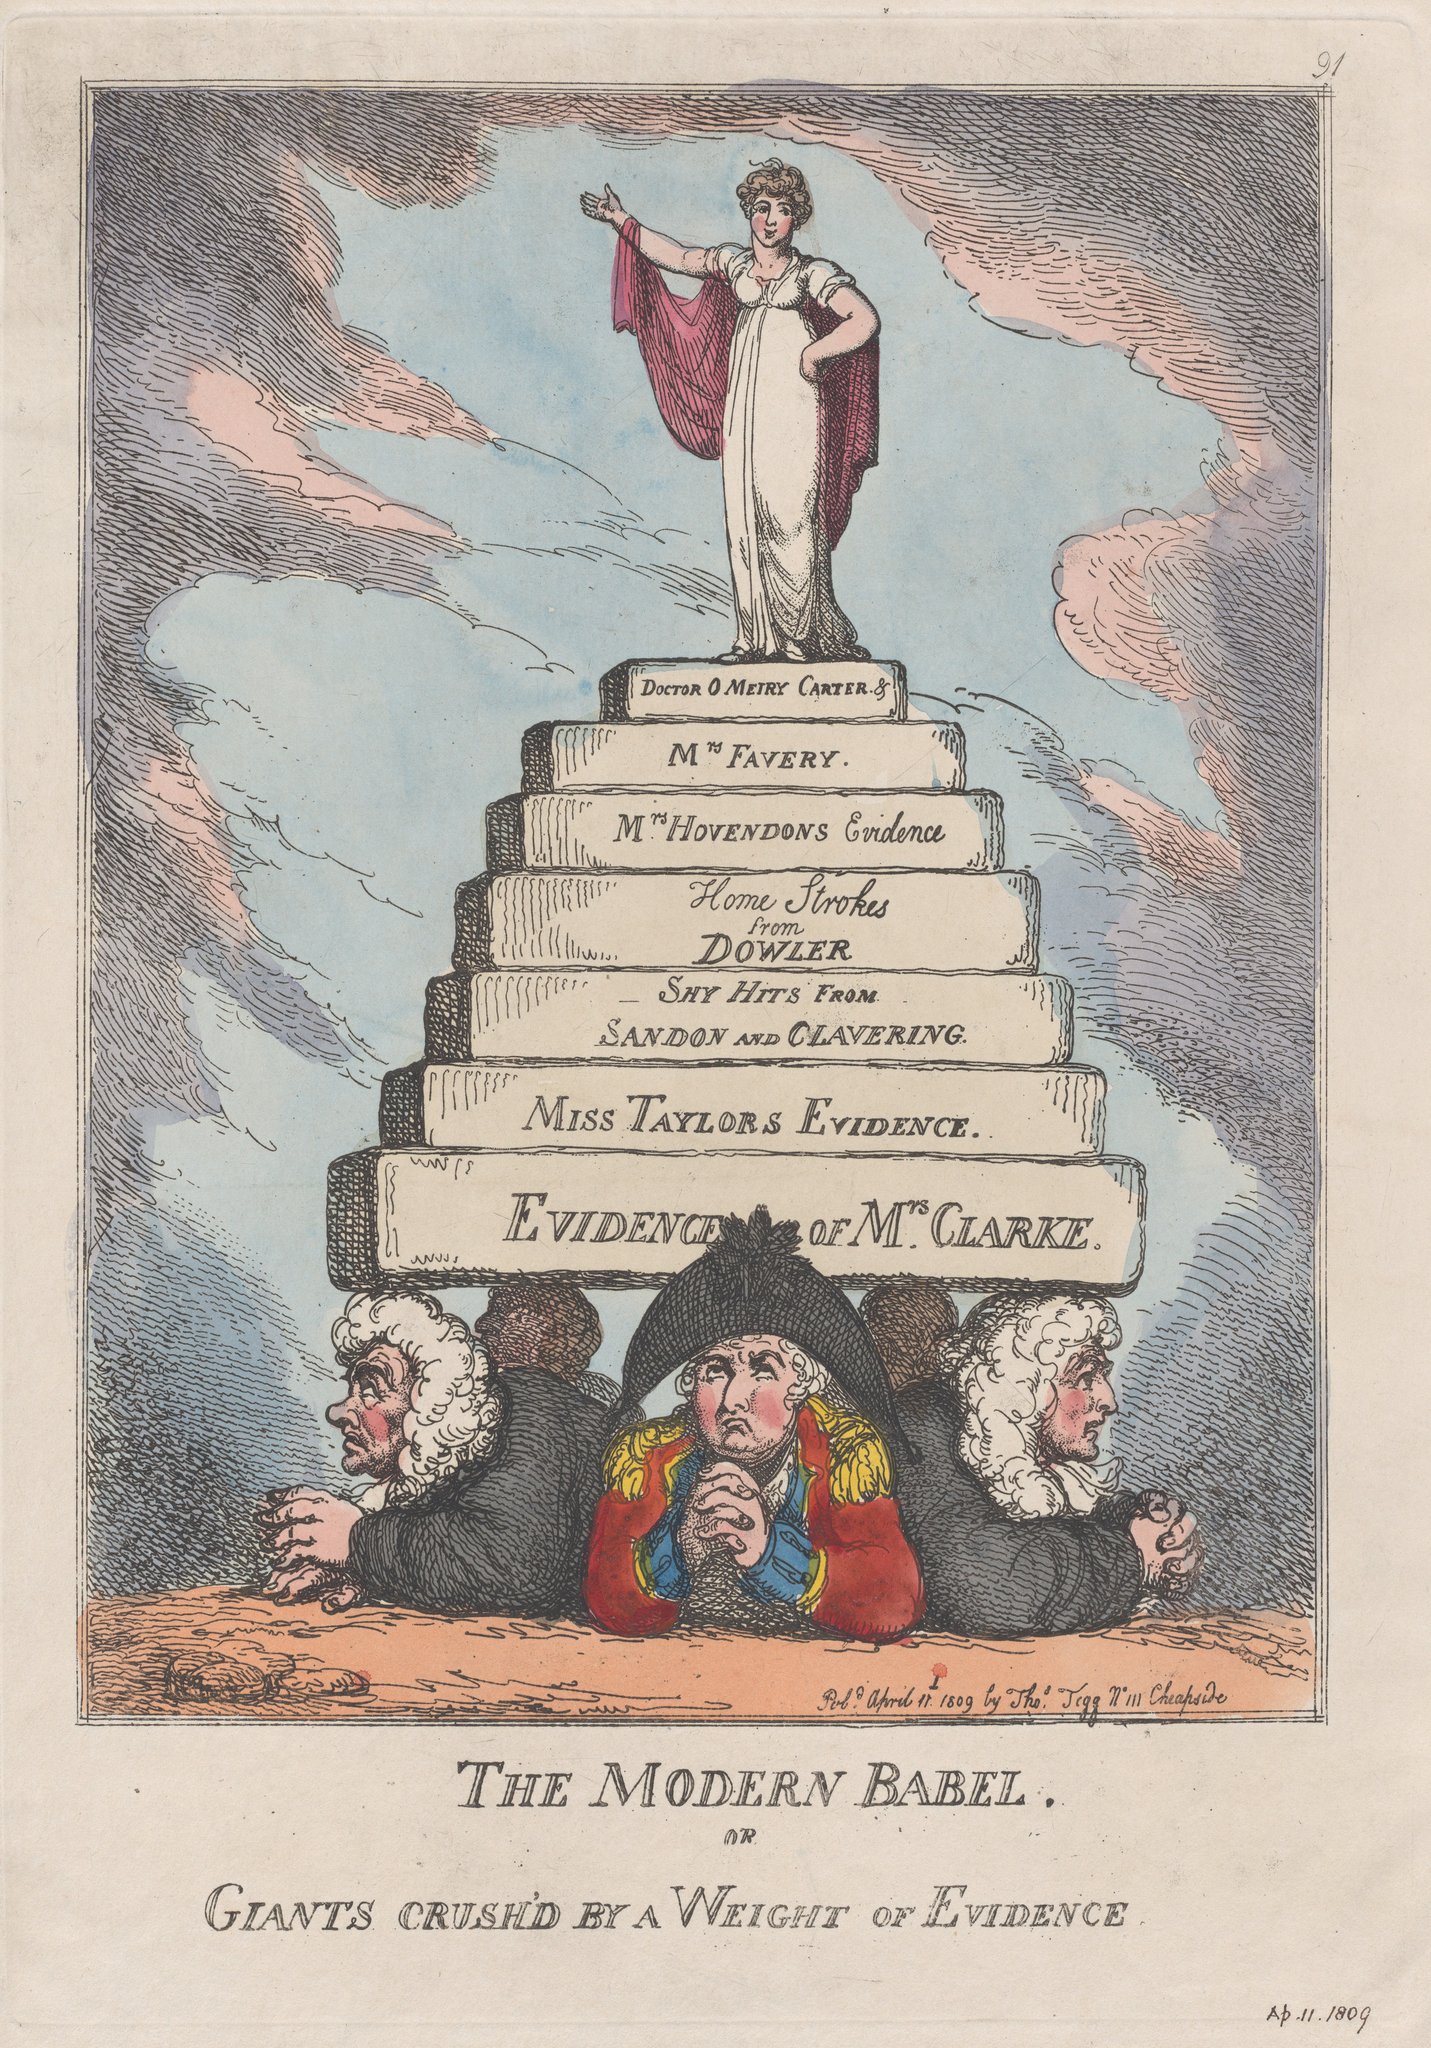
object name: print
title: The Modern Babel, or Giants Crushed by a Weight of Evidence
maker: thomas rowlandson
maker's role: artist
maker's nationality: british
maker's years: 1757-1827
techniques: etching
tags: satire,men,women,politics